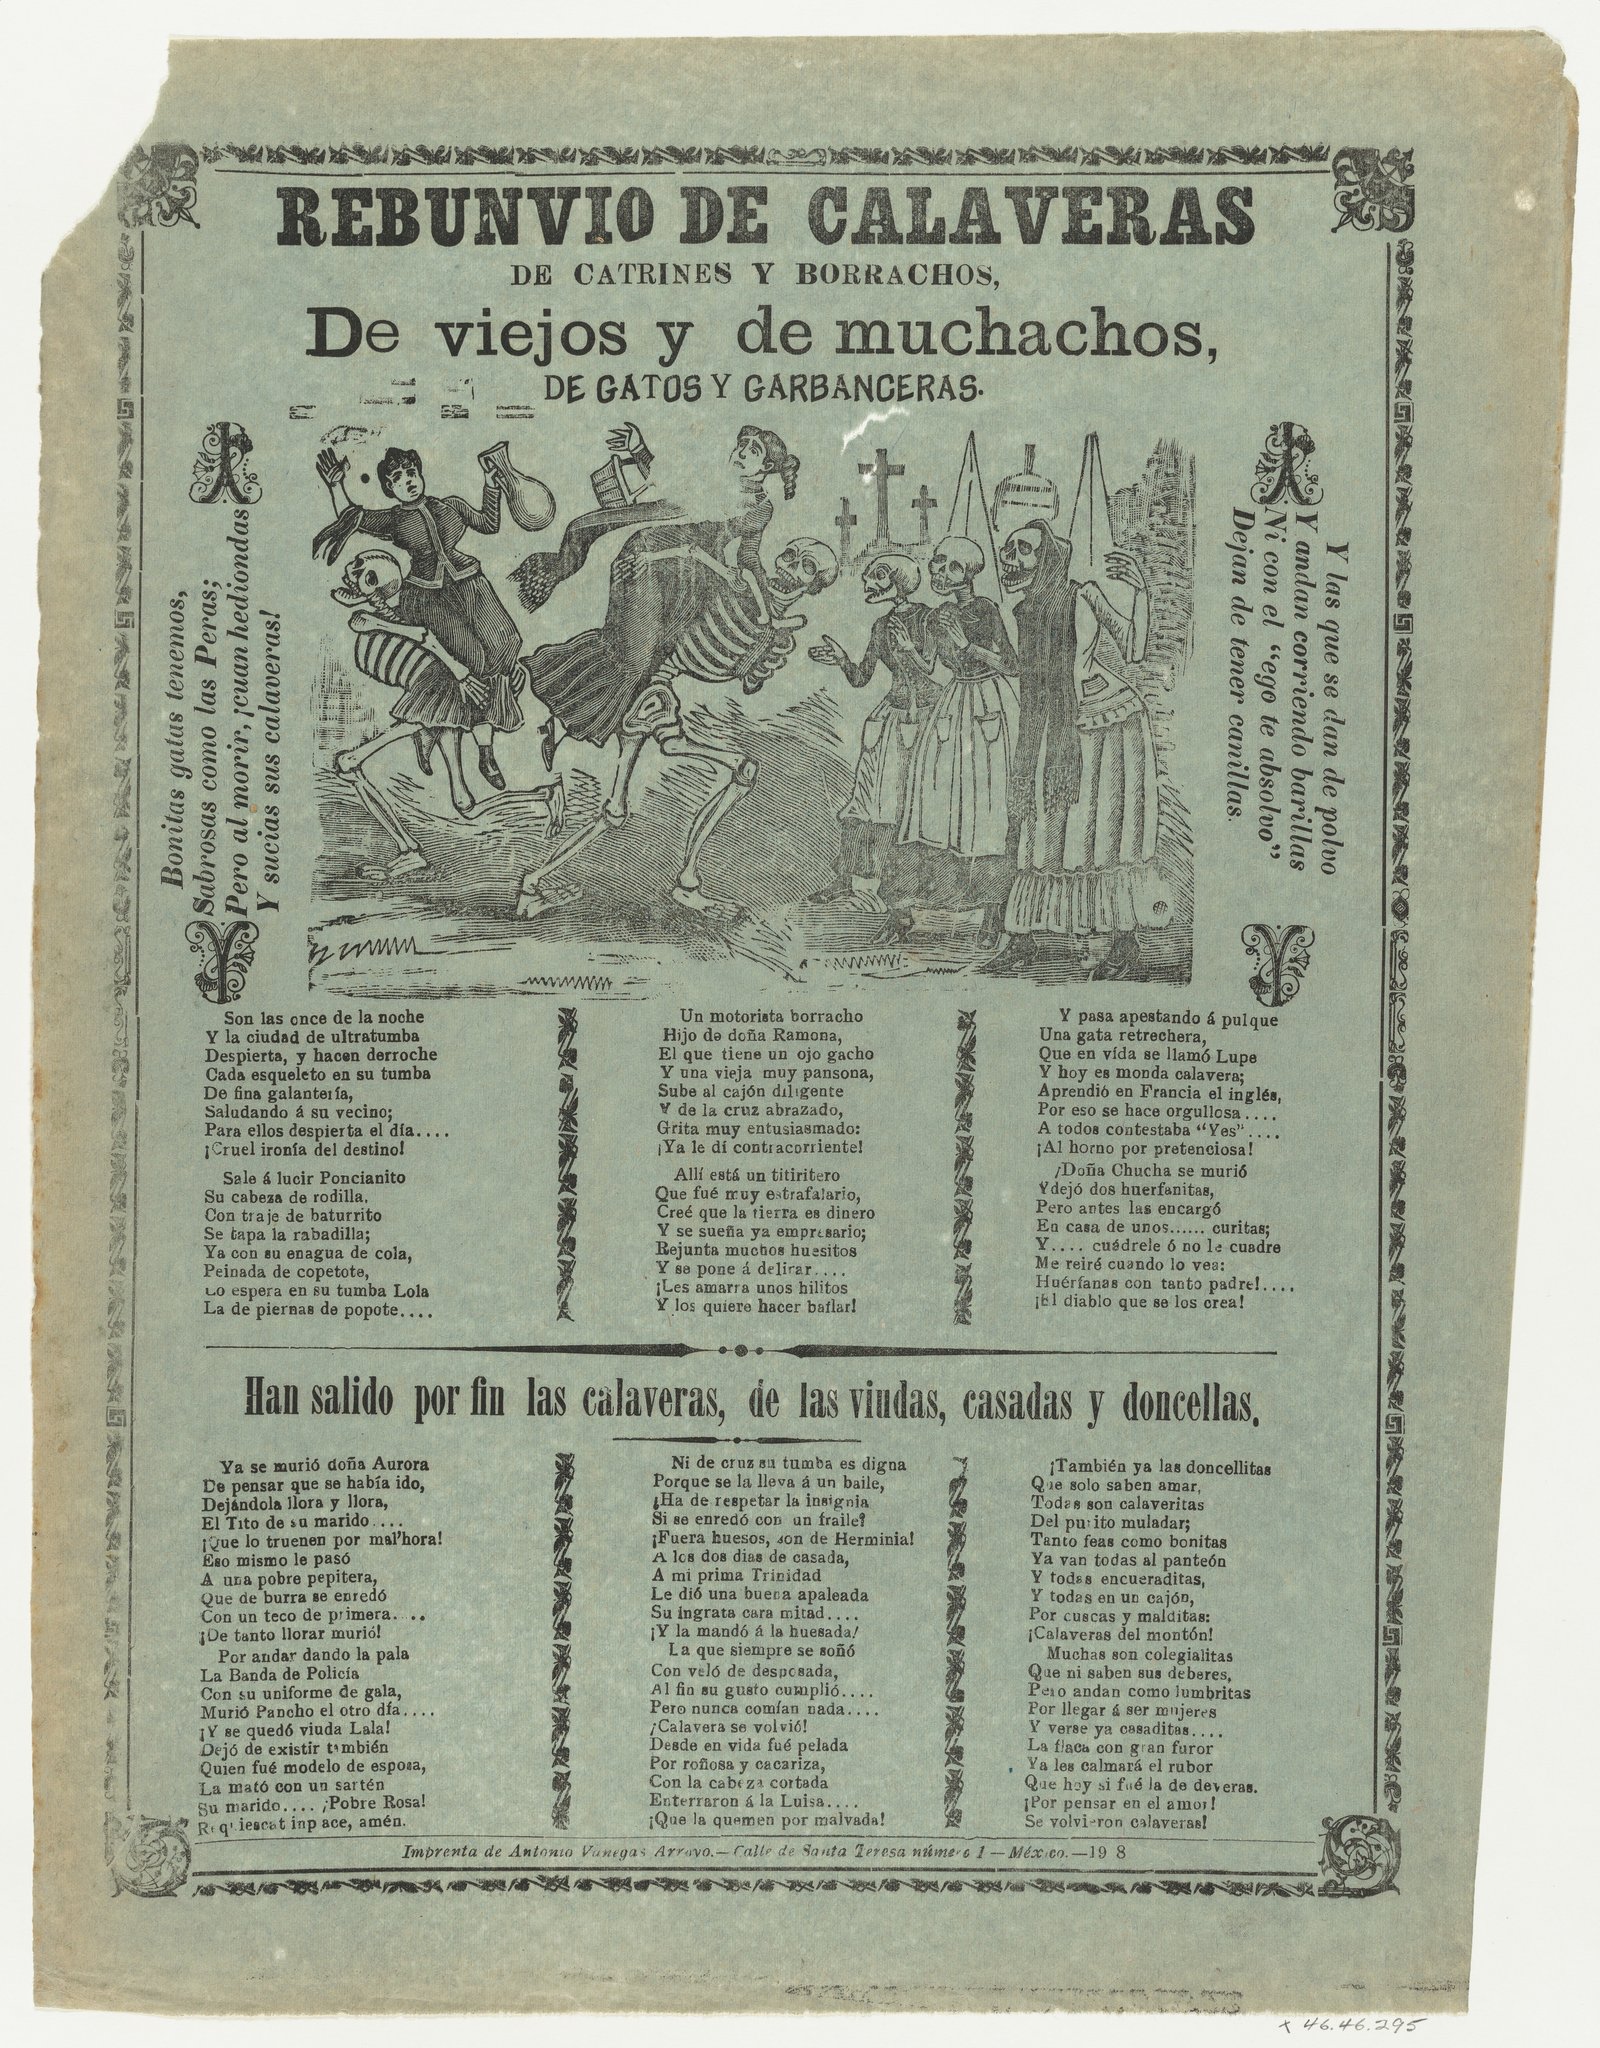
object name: print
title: Broadsheet relating to the racket caused by the skeletons (catrines and drunkards), a corrido (ballad) in the bottom section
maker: Anonymous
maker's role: artist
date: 1908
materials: paper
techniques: letterpress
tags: skeletons